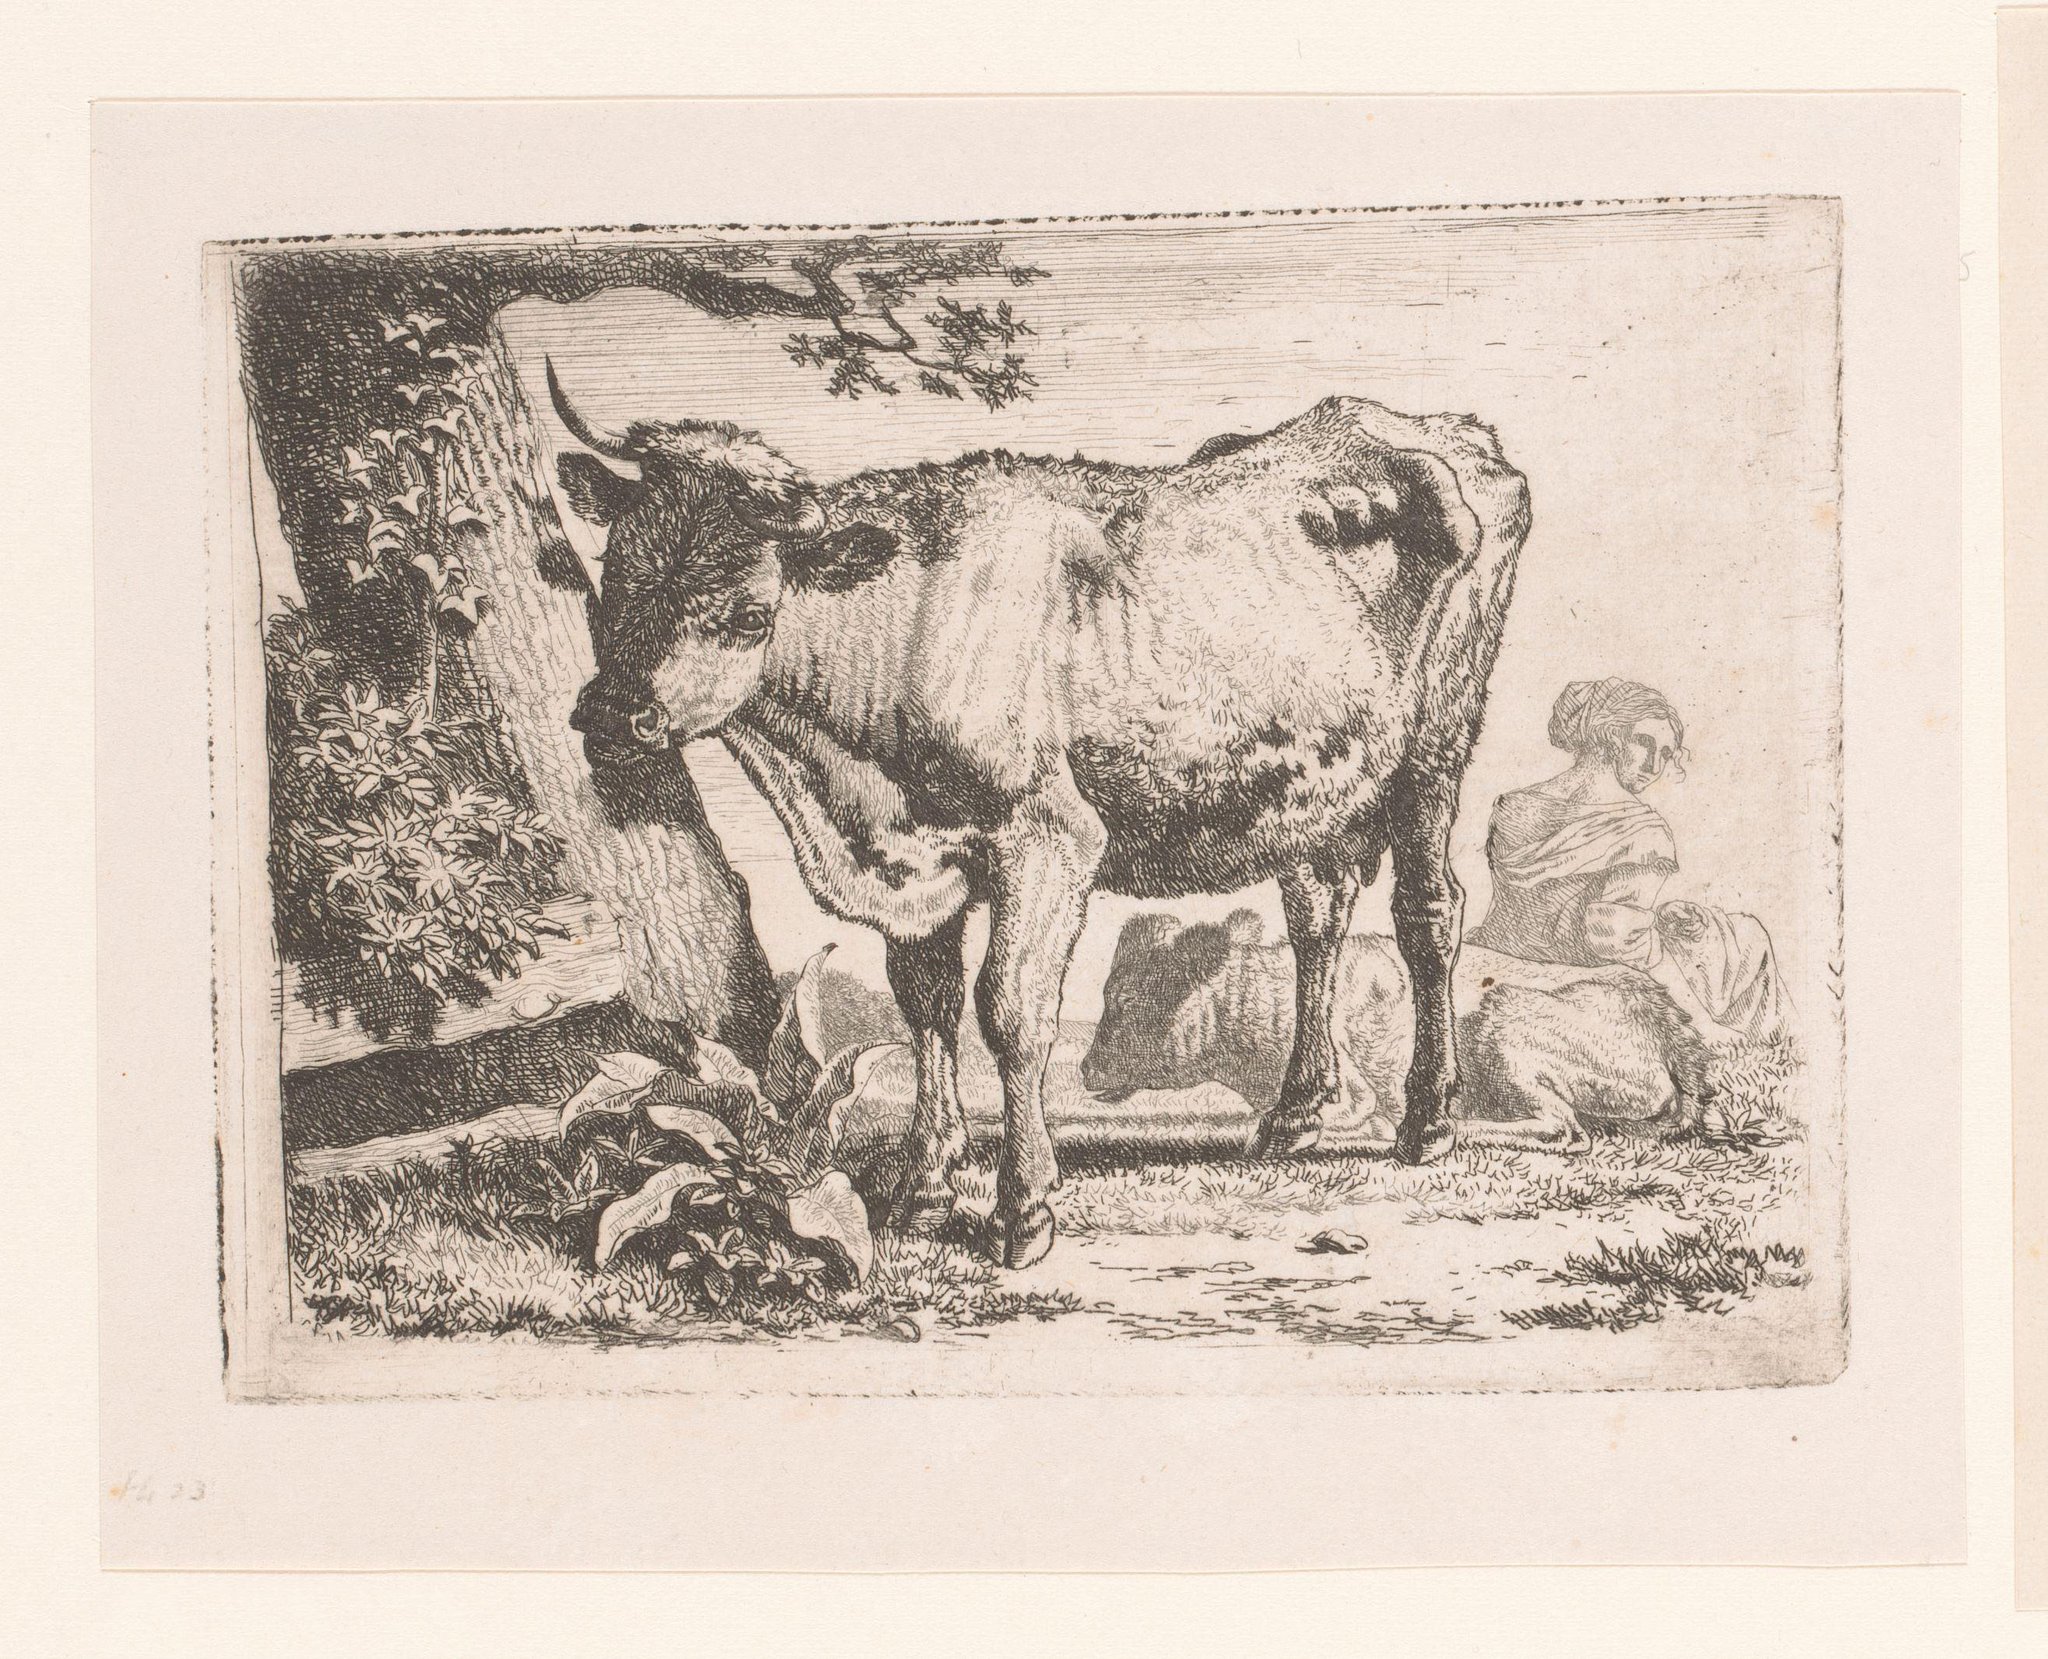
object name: print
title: Vrouw zittend bij een koe en haar kalf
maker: jean louis demarne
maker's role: draughtsman, painter, print maker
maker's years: 1752-1829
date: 1762-1829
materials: paper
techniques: etching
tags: cow, adult woman, calf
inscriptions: collector's mark: Lugt 2228